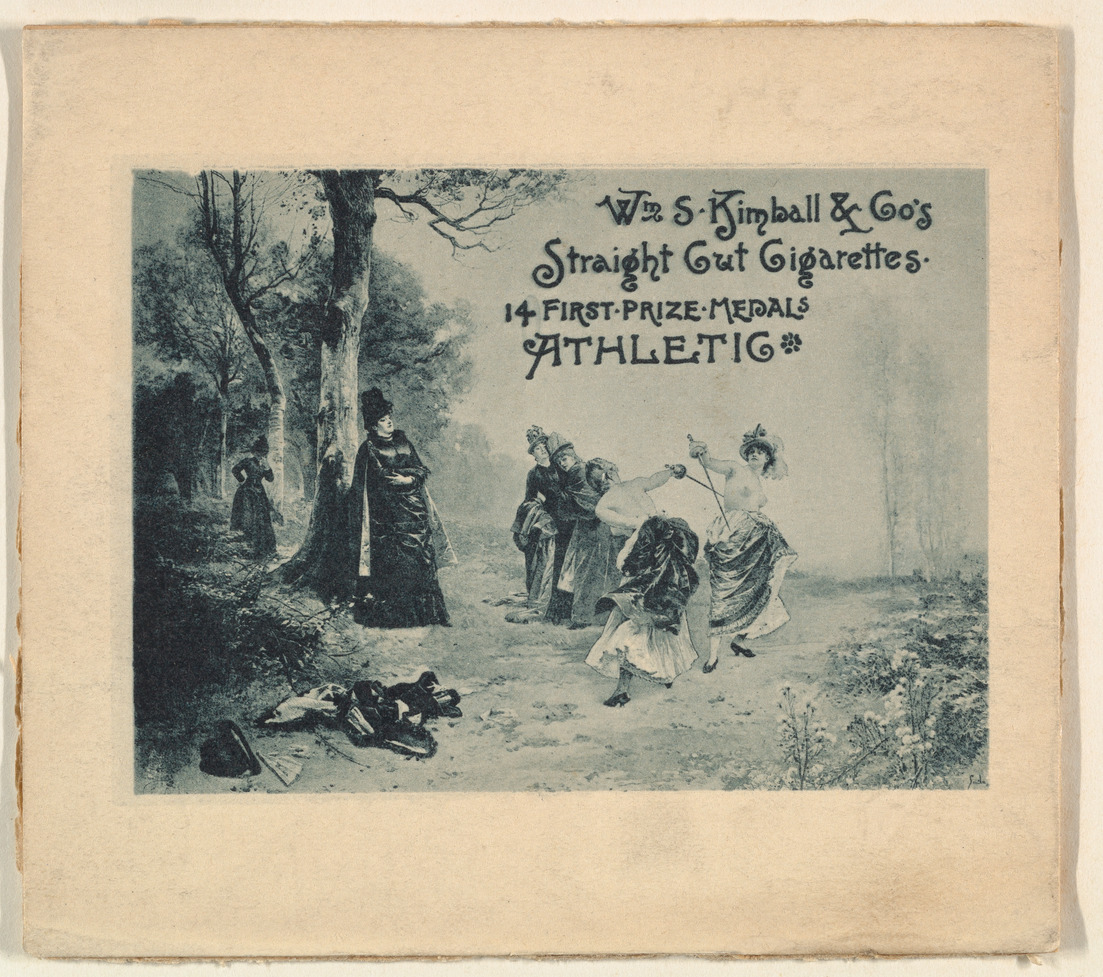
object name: print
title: Athletic, from the Sports and Art Subjects series (N197) issued by Wm. S. Kimball & Co.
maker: william s. kimball & company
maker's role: publisher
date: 1889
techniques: color lithograph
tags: swords,women,female nudes